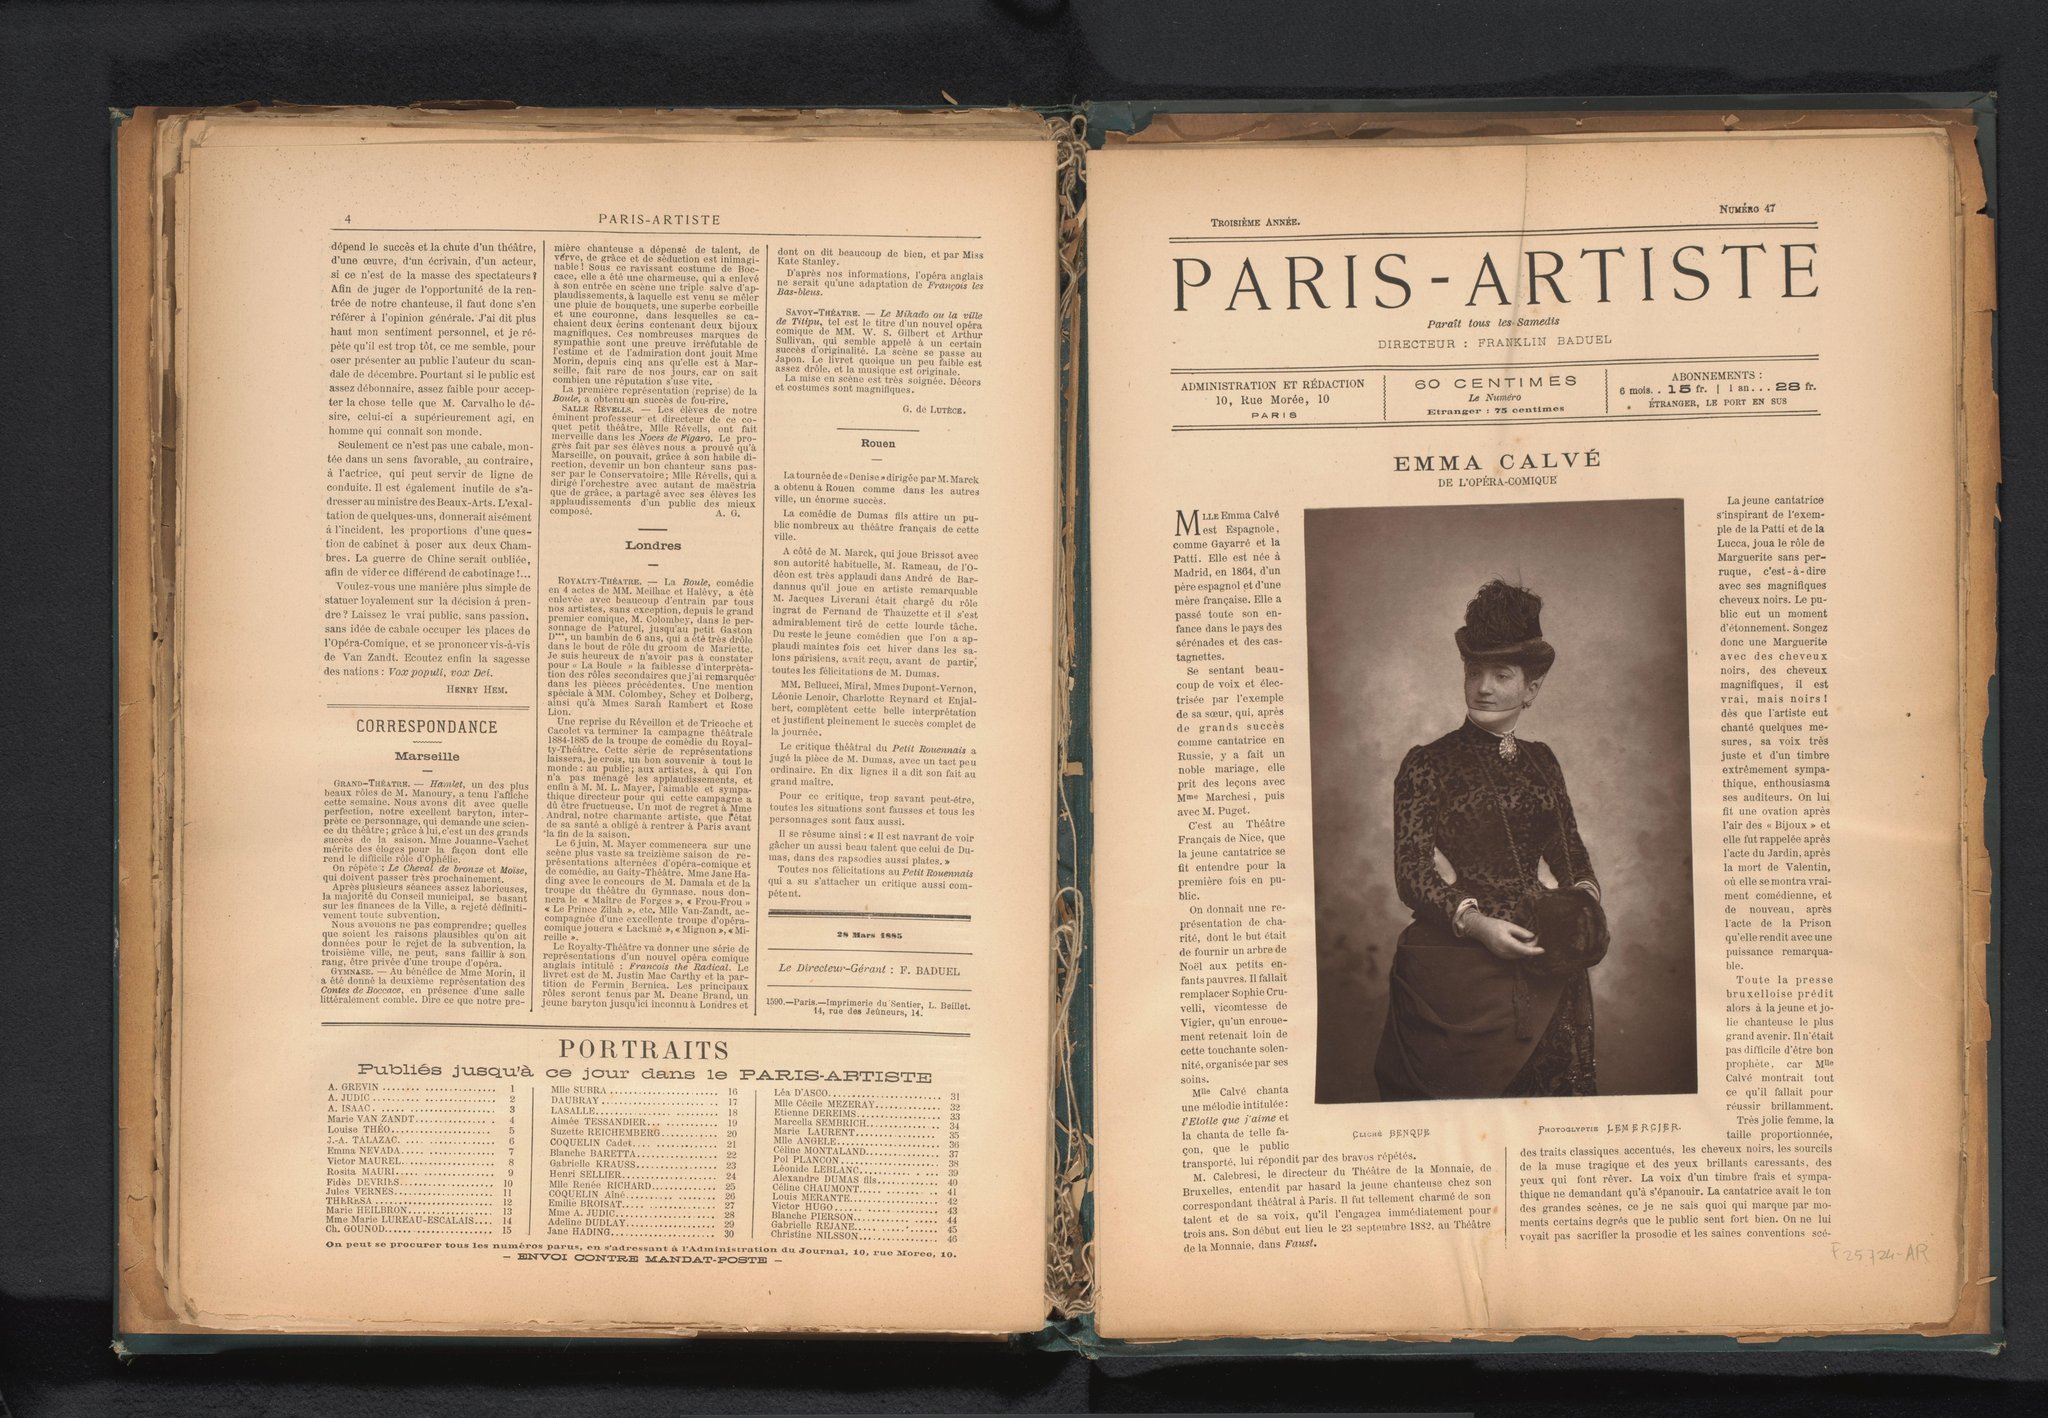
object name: photomechanical print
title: Portret van Emma Calvé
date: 1880-1885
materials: paper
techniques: woodburytype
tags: historical persons - bb - woman, opera-singer (female)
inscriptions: inscription: ‘De l'opéra-comique’